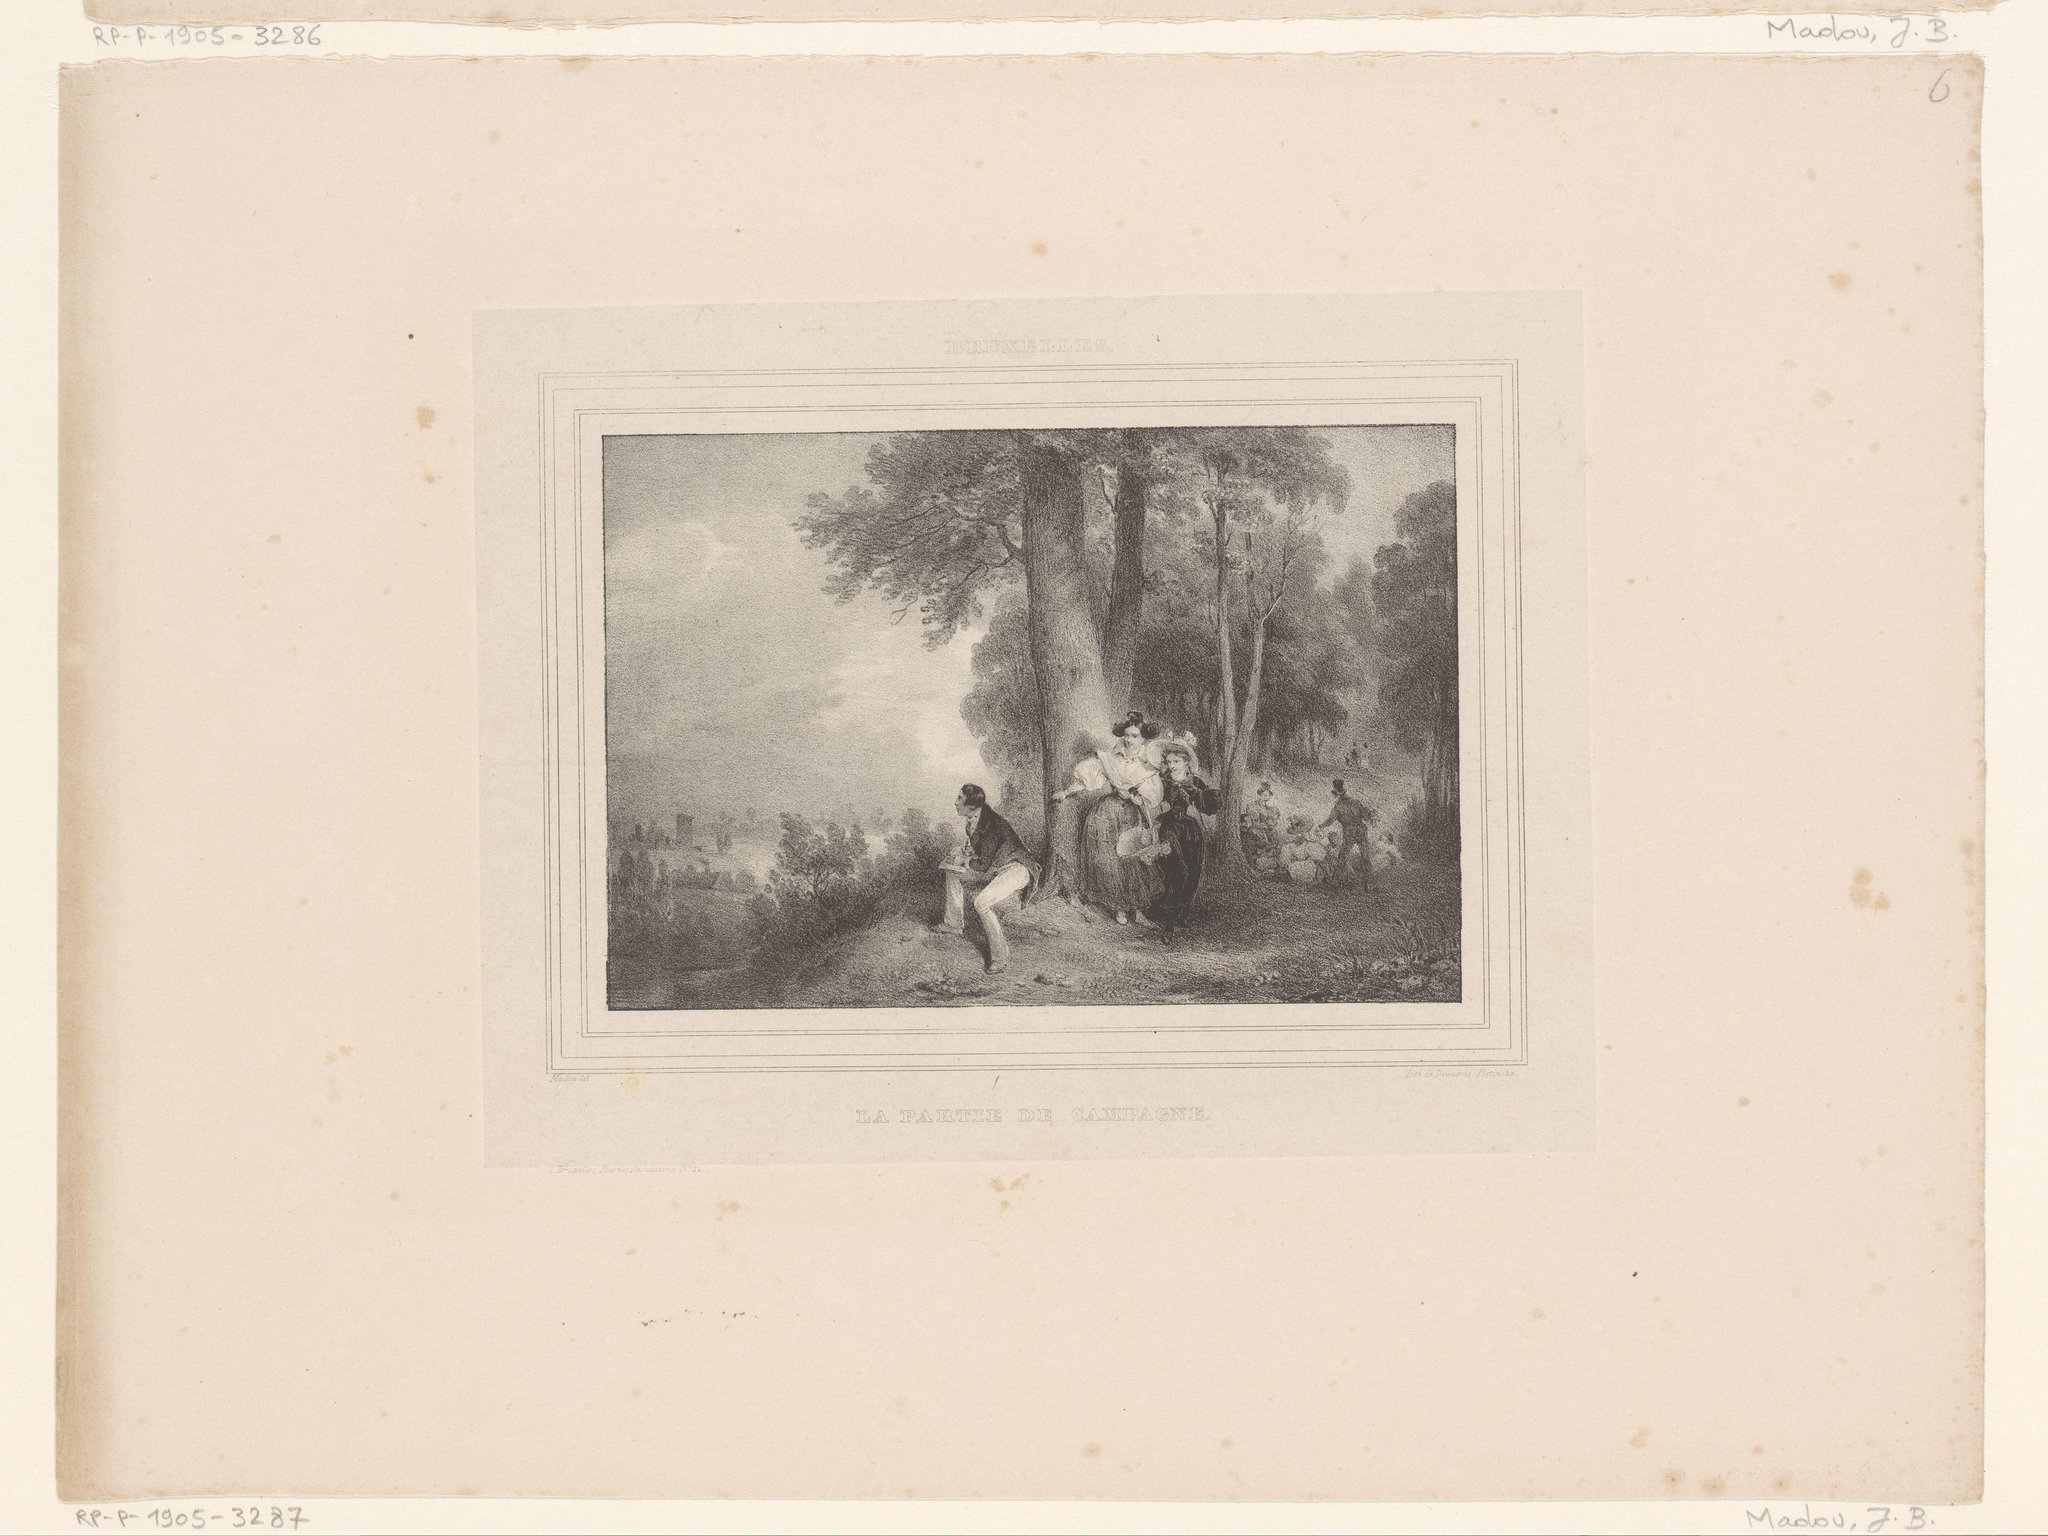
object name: print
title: Bruxelles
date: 1831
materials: paper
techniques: lithograph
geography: brussels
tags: low hill country, forest, wood (+ landscape with figures, staffage), brussels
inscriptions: collector's mark: Lugt 2228